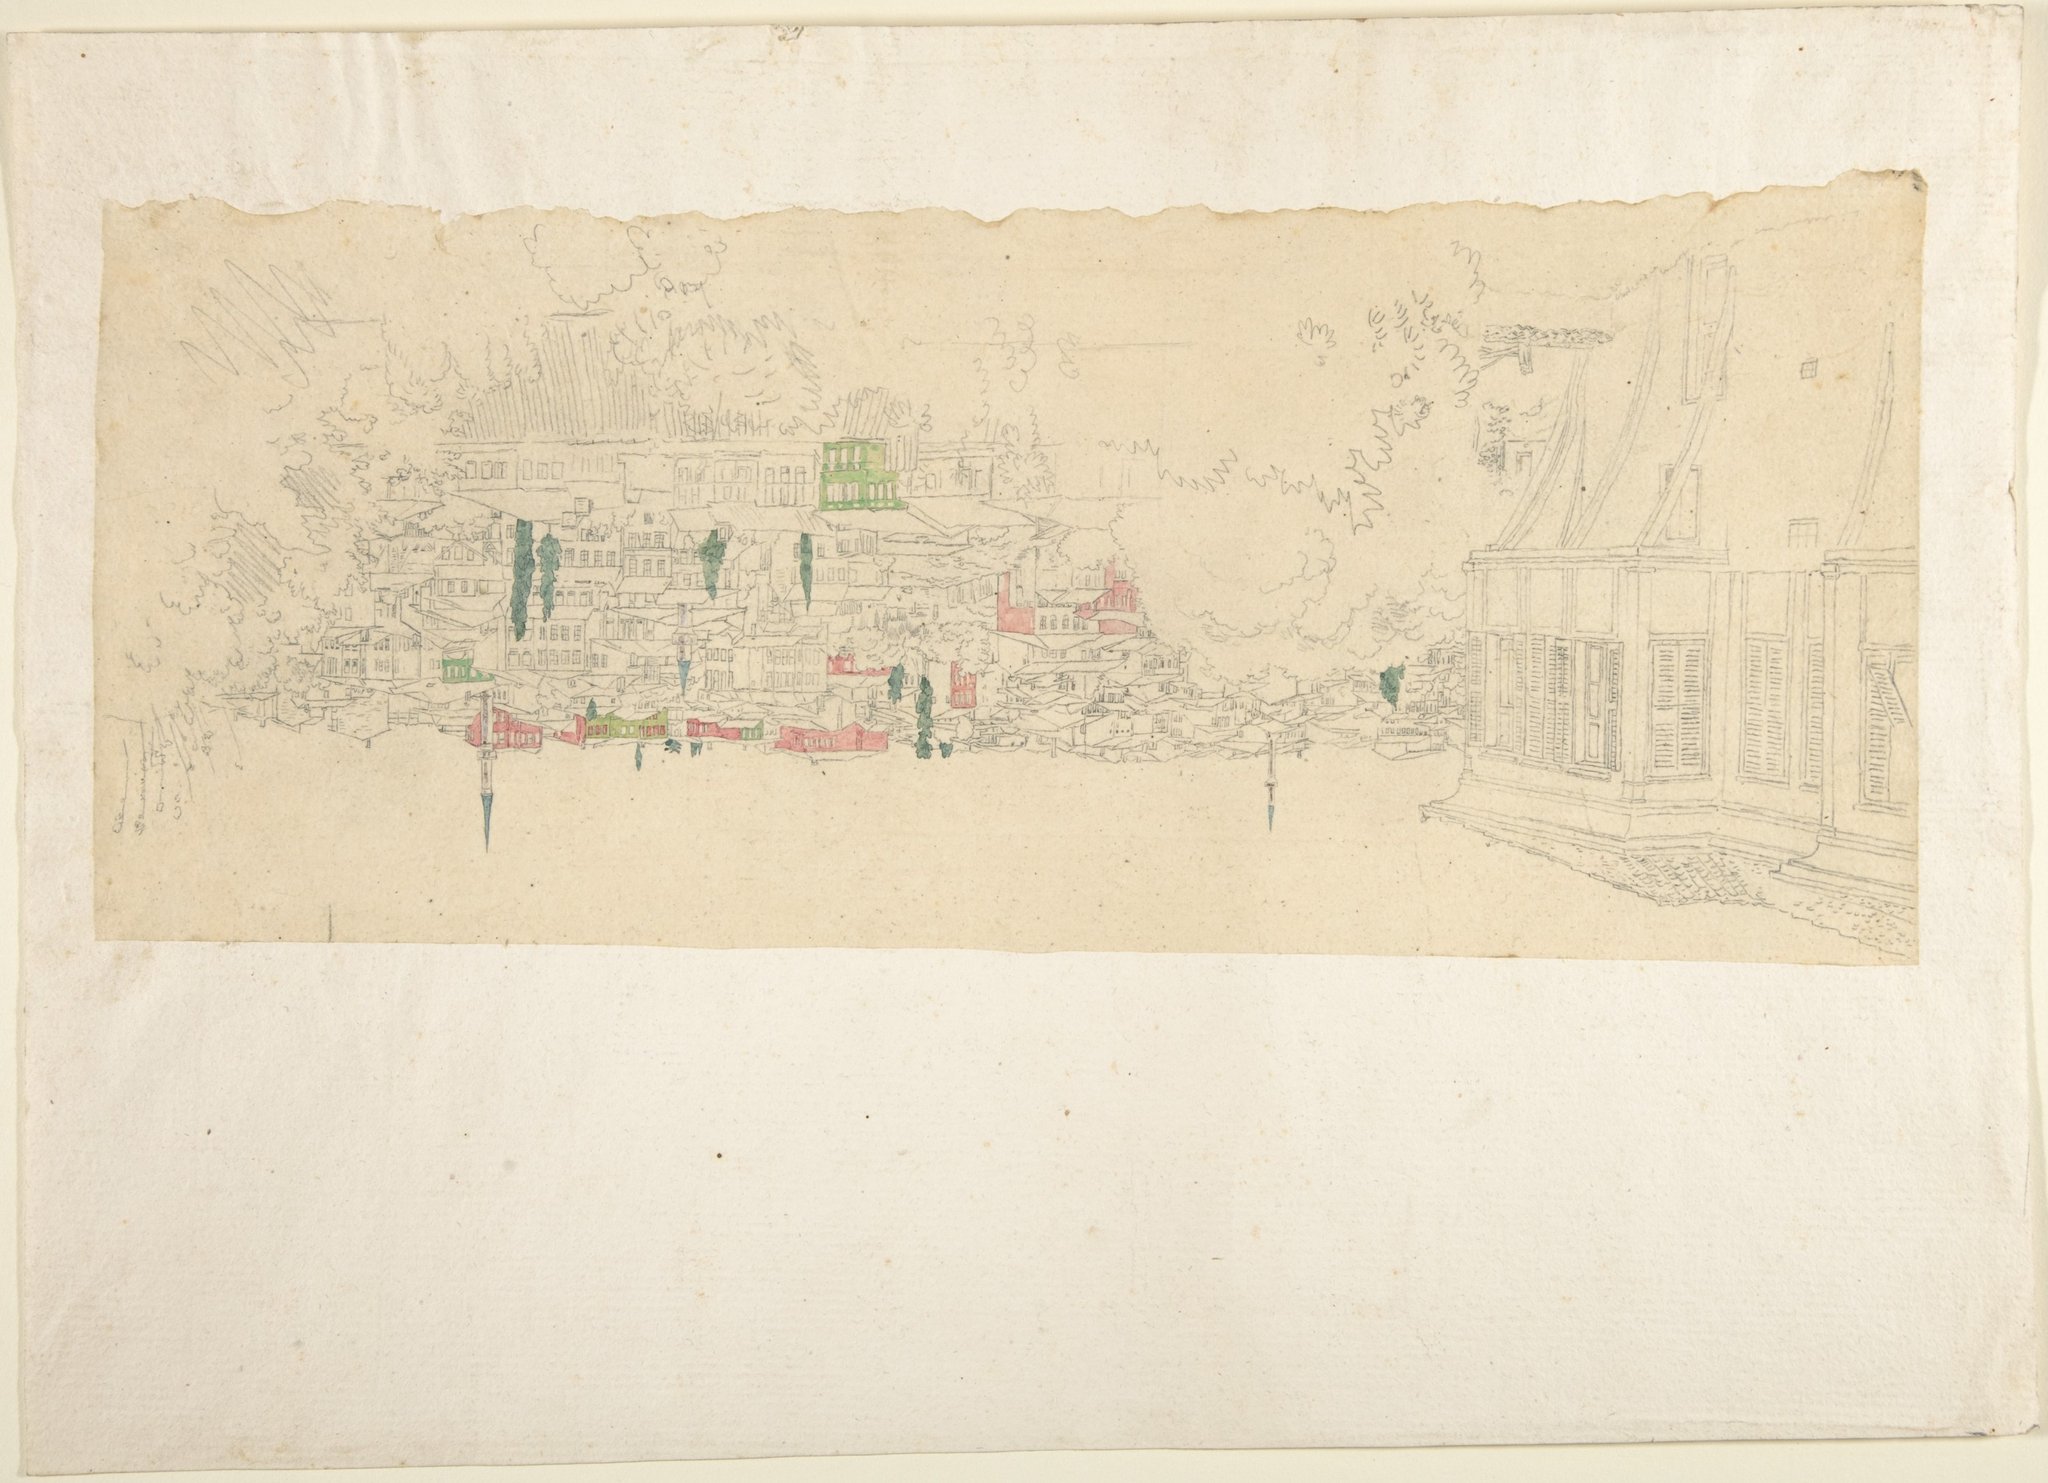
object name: drawing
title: View of Town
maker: franz von hauslab the younger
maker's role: artist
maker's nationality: austrian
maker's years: 1798-1883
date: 1801-1900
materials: paper, pencil, watercolor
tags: houses,towns